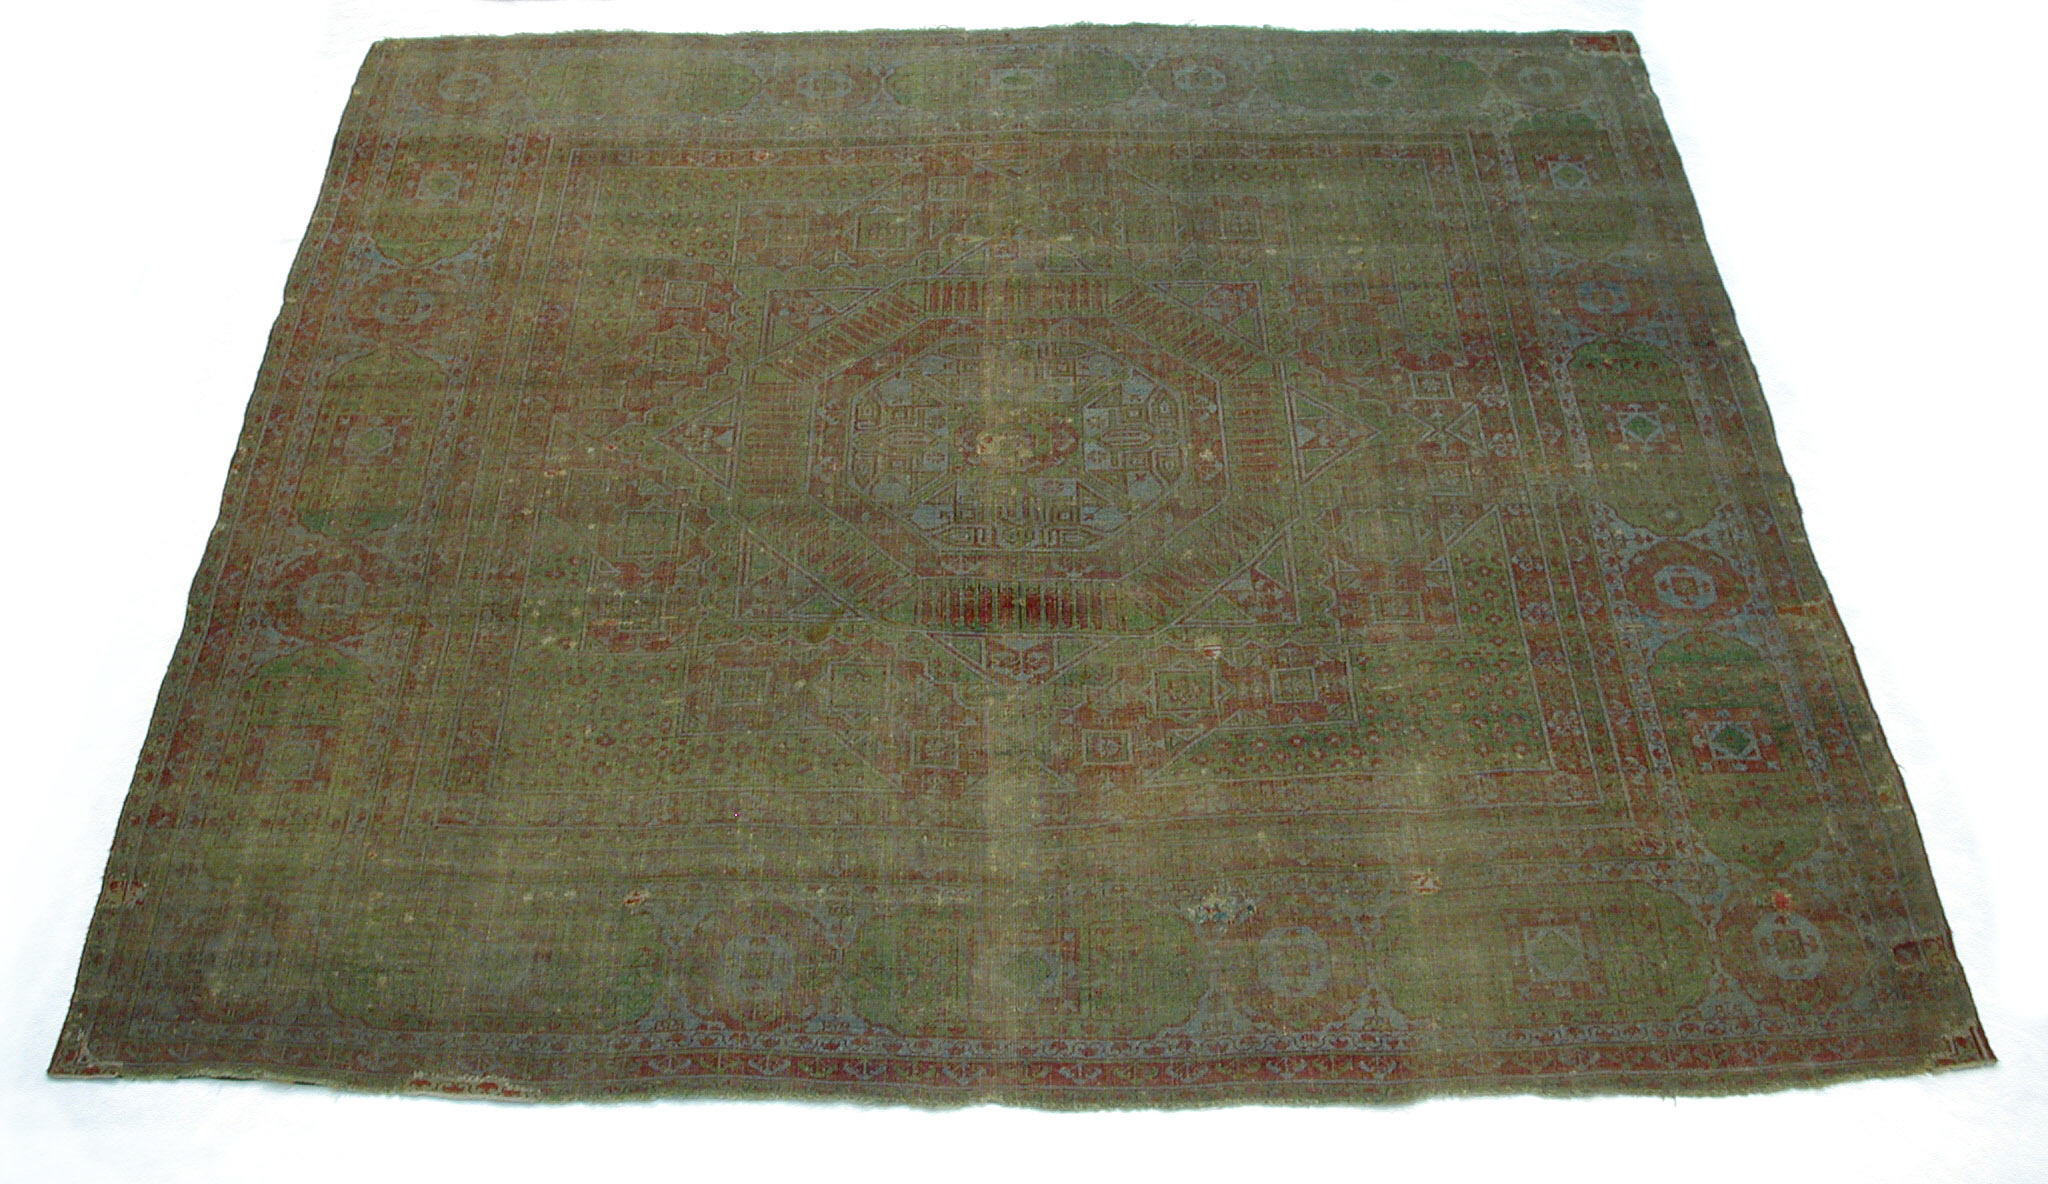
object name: carpet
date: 1667-1700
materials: wool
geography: egypt